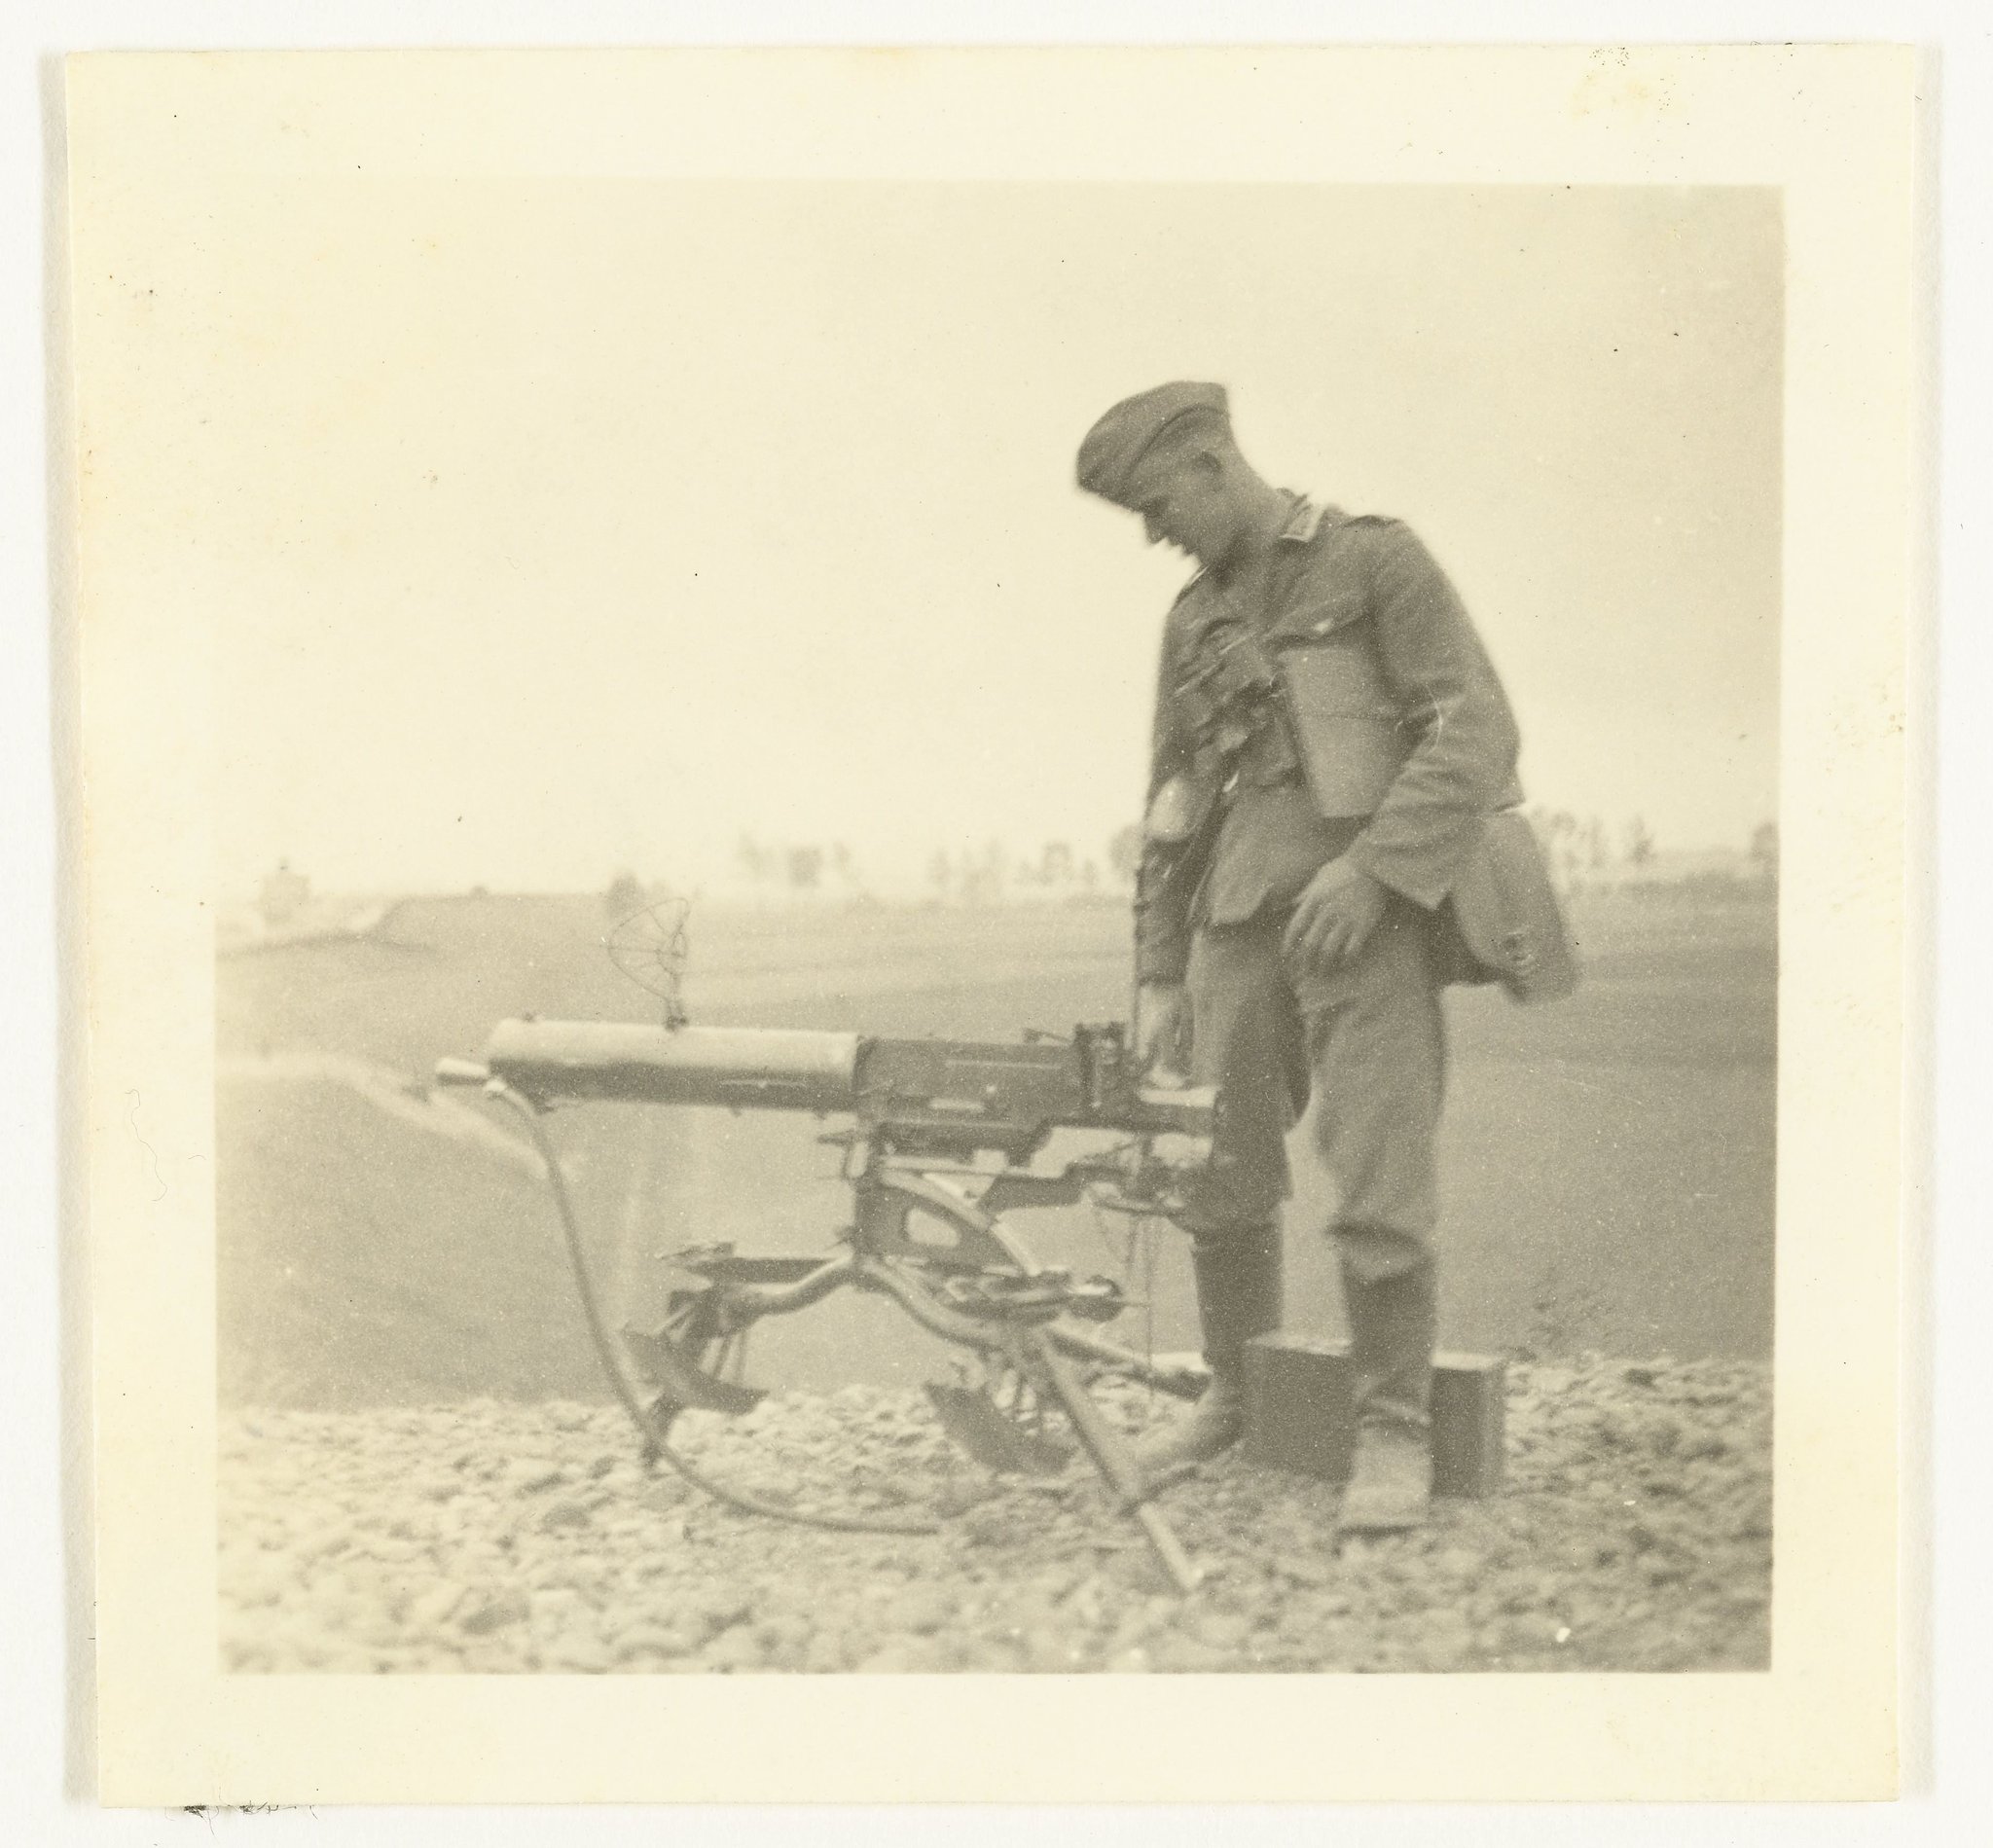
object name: photograph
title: Wehrmacht militair bij machinegeweer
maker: Anonymous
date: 1941-1942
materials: photographic support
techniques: gelatin silver print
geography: netherlands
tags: firearms (with name), occupation ~ war, netherlands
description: Een Duitse militair staat bij een machinegeweer in een open terrein. Aan zijn voeten staat een kistje.